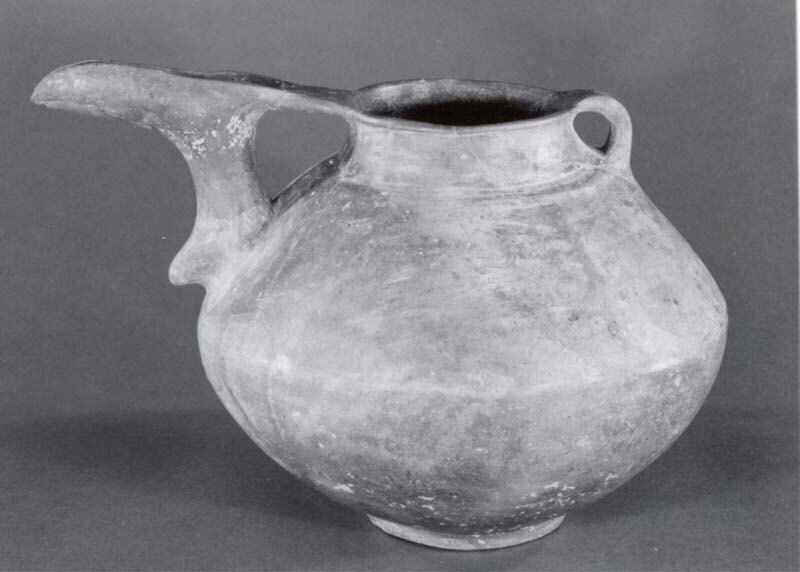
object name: pitcher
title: Spouted pitcher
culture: iranian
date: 900-801 BCE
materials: ceramic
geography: iran